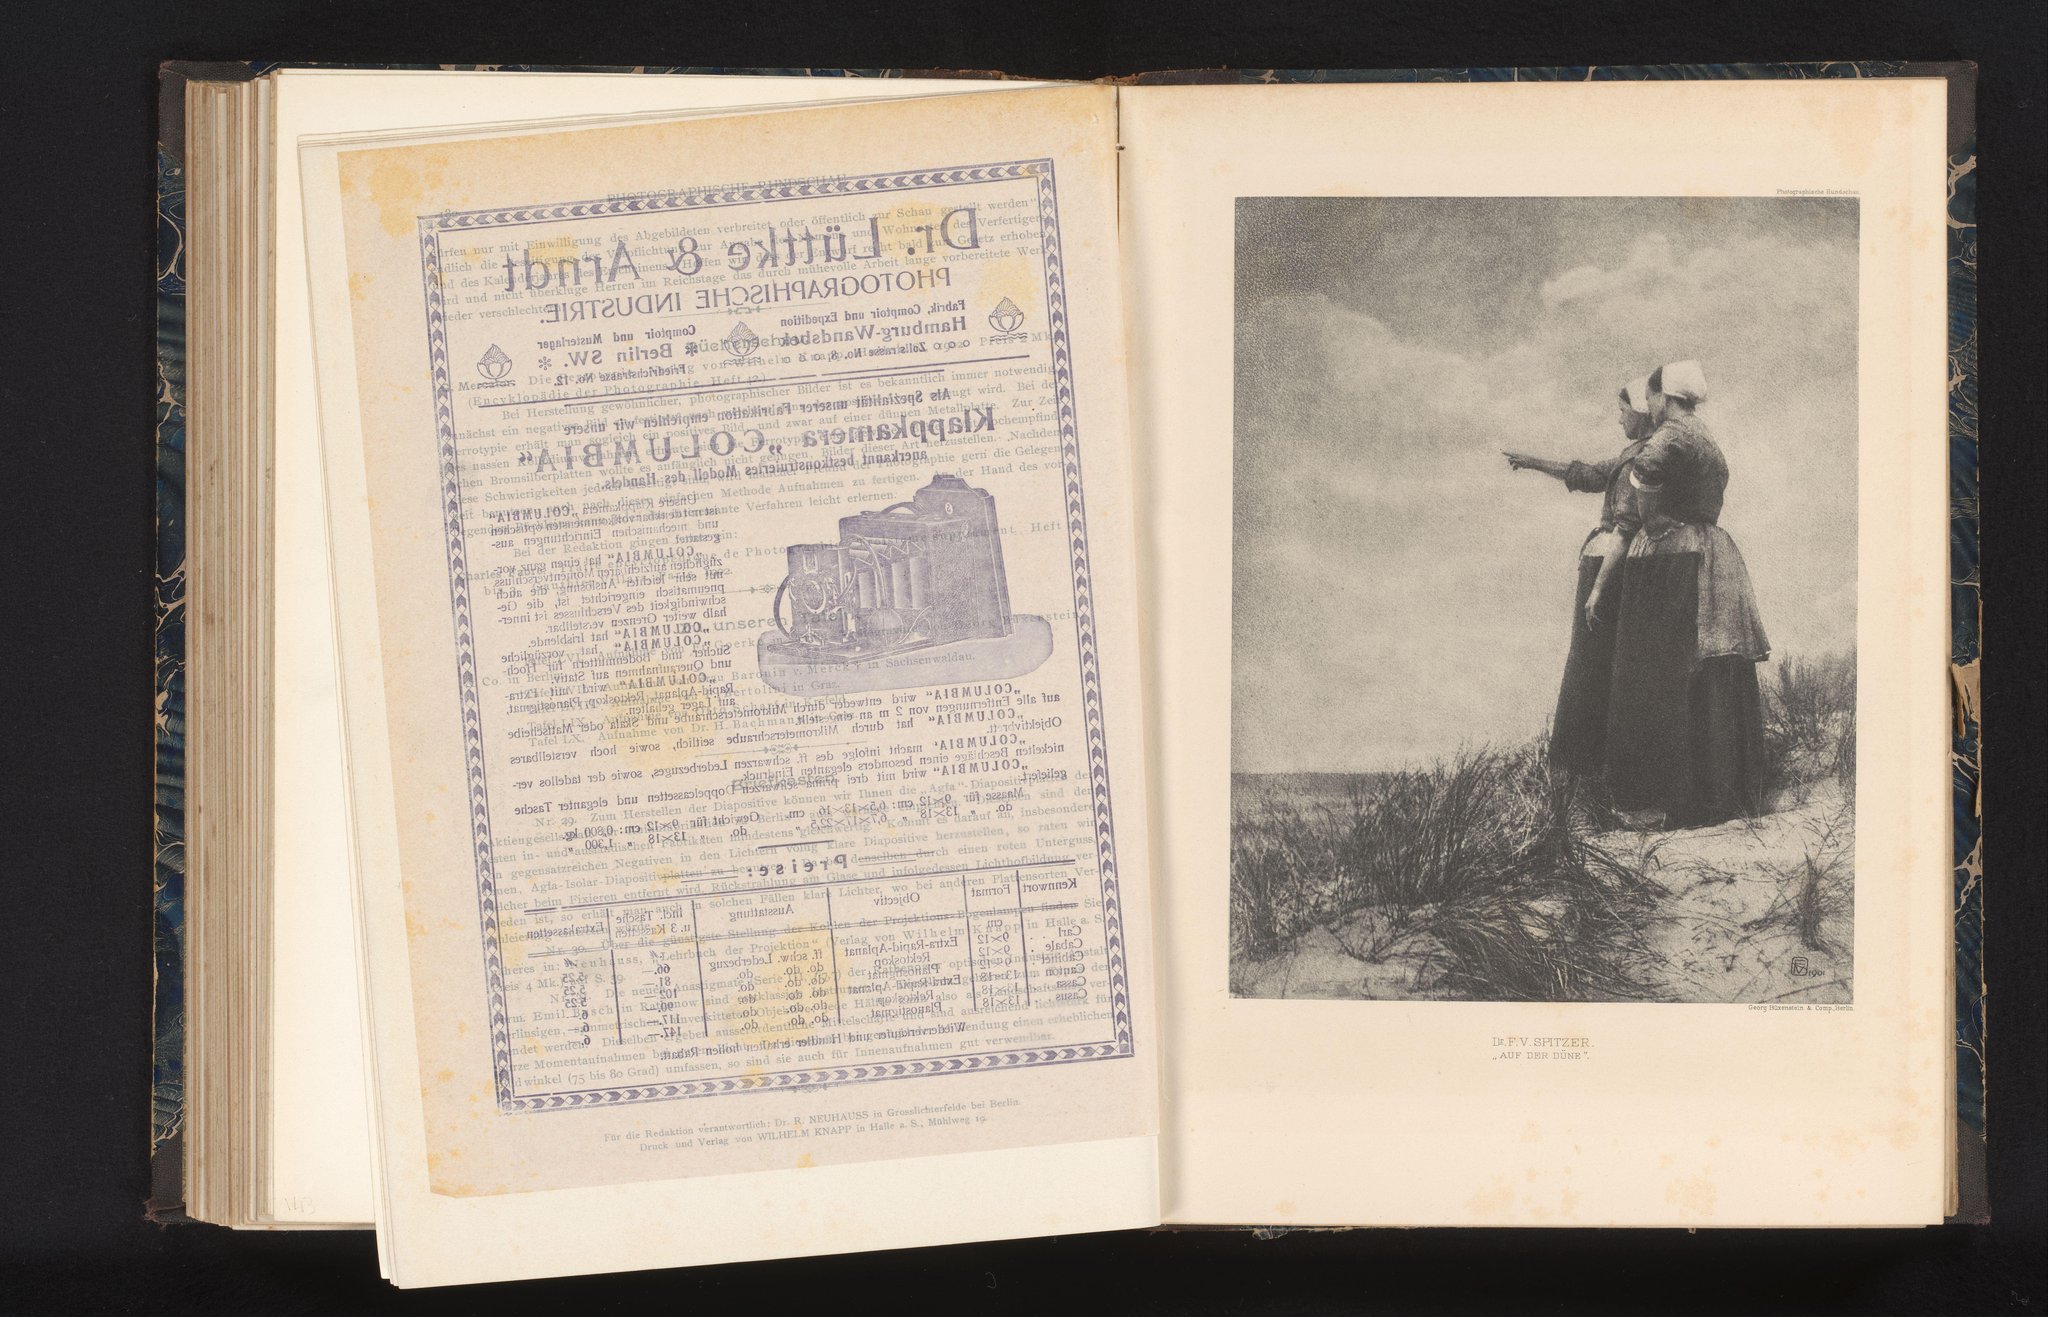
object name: page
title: Auf der Düne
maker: friedrich victor spitzer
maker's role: fotograaf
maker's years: 1859-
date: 1897-1902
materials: paper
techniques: photoaquatint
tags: dune coast, adult woman, folk costume, regional costume